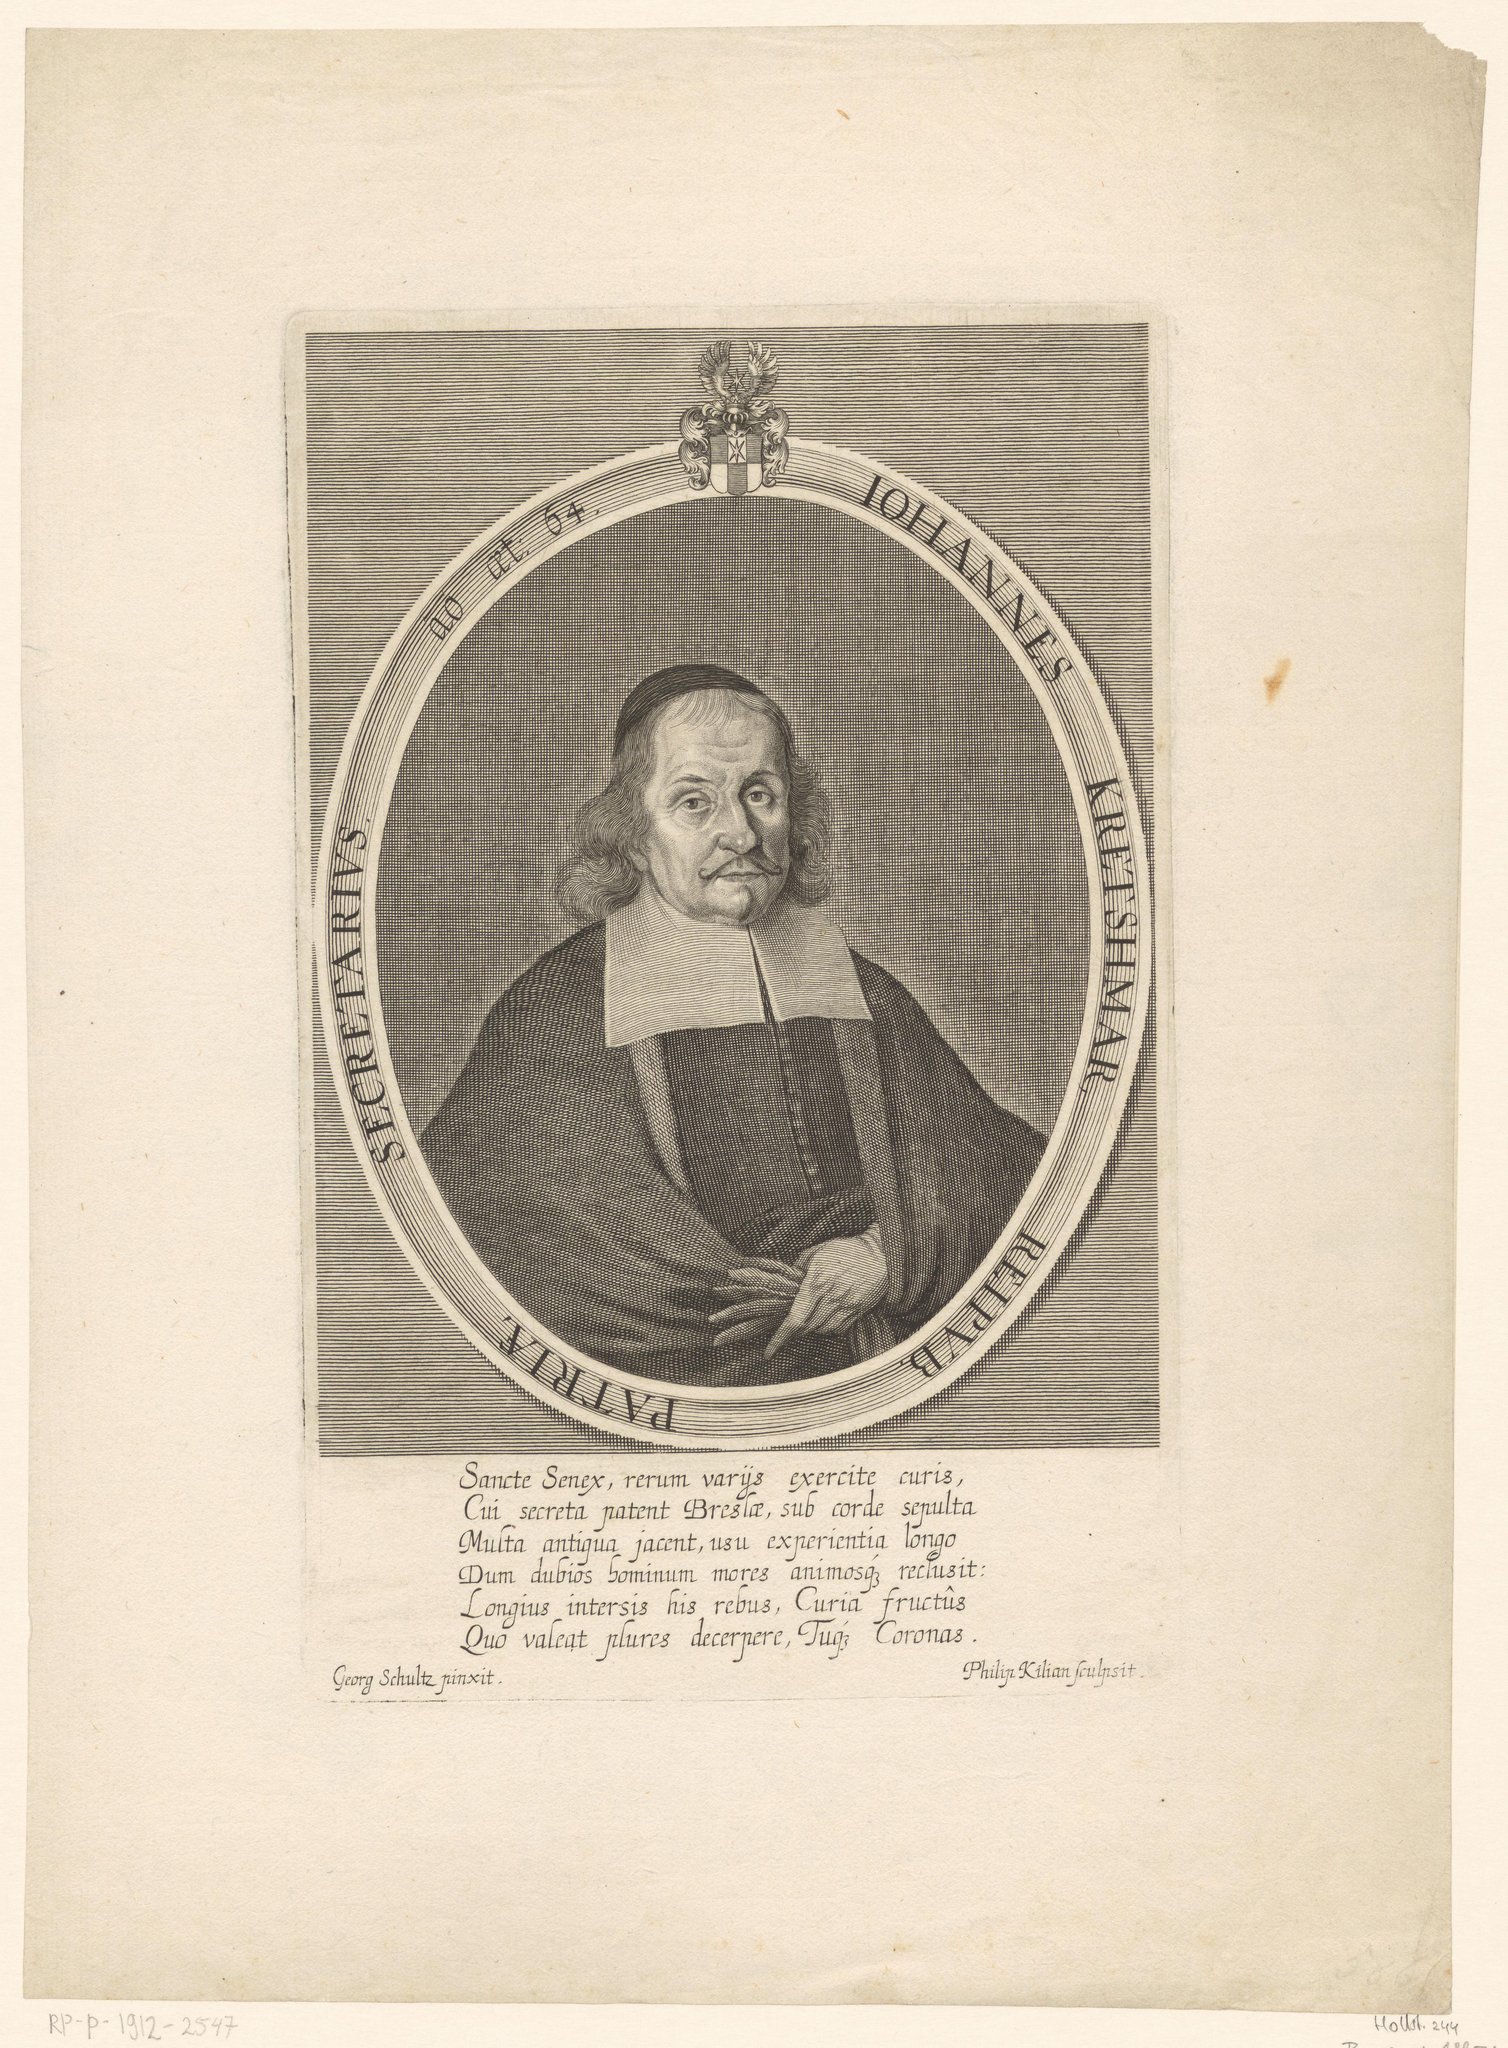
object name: print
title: Portret van Johannes Cretschmar op 64-jarige leeftijd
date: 1638-1693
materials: paper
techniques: engraving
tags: historical persons, lawyer, attorney at law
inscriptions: collector's mark: Lugt 2228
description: Tekst in het Latijn in de omlijsting en in de ondermarge.